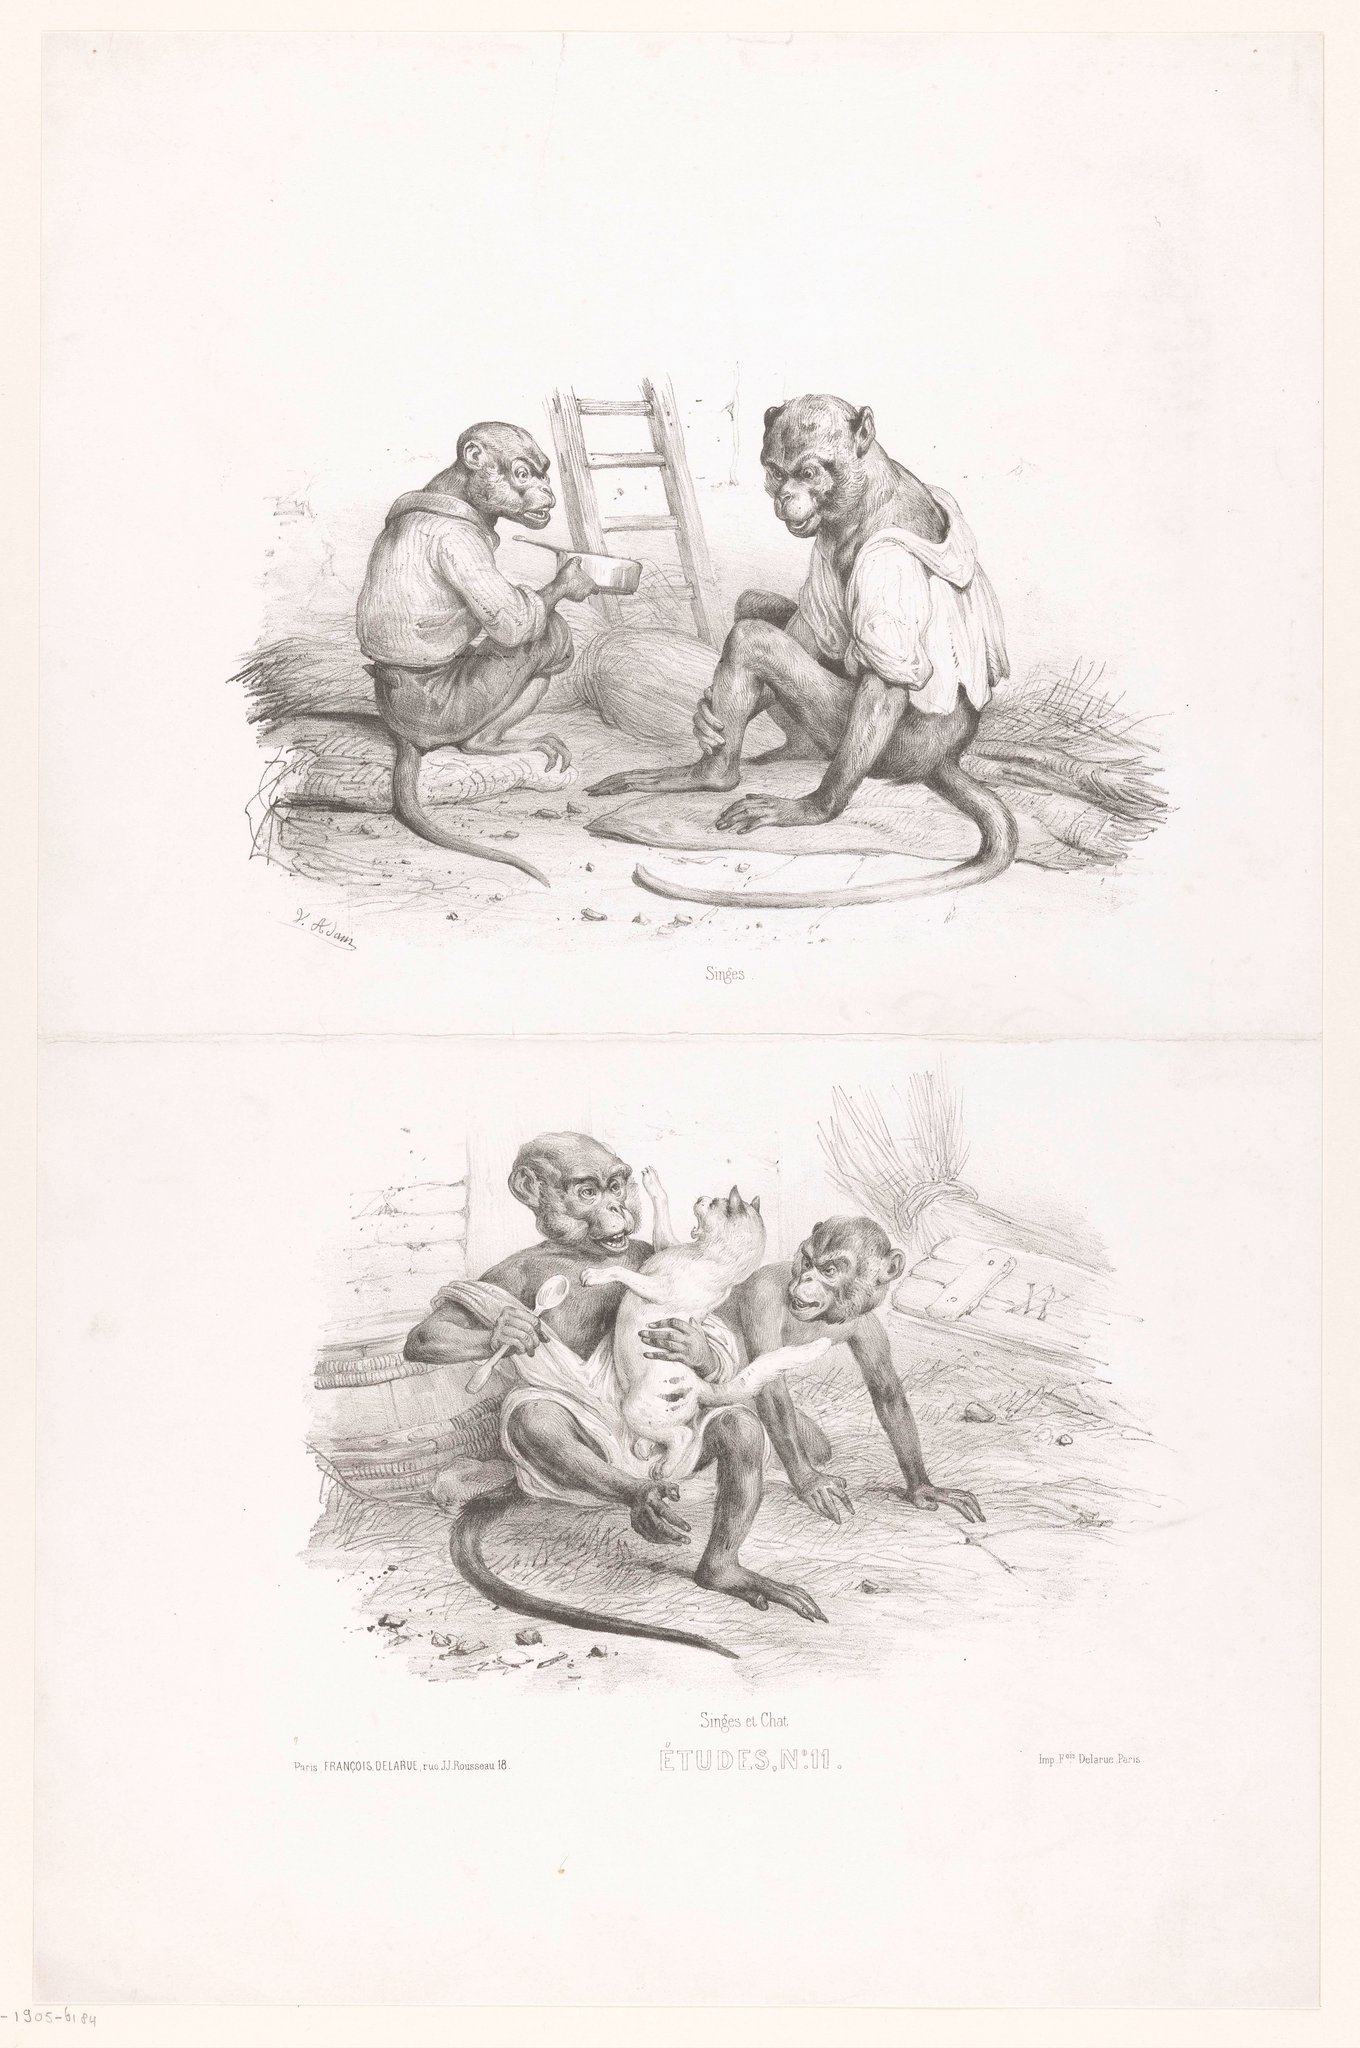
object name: print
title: Singes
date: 1855-1878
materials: paper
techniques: lithography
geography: paris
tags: cat, monkeys, apes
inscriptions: collector's mark: Lugt 2228